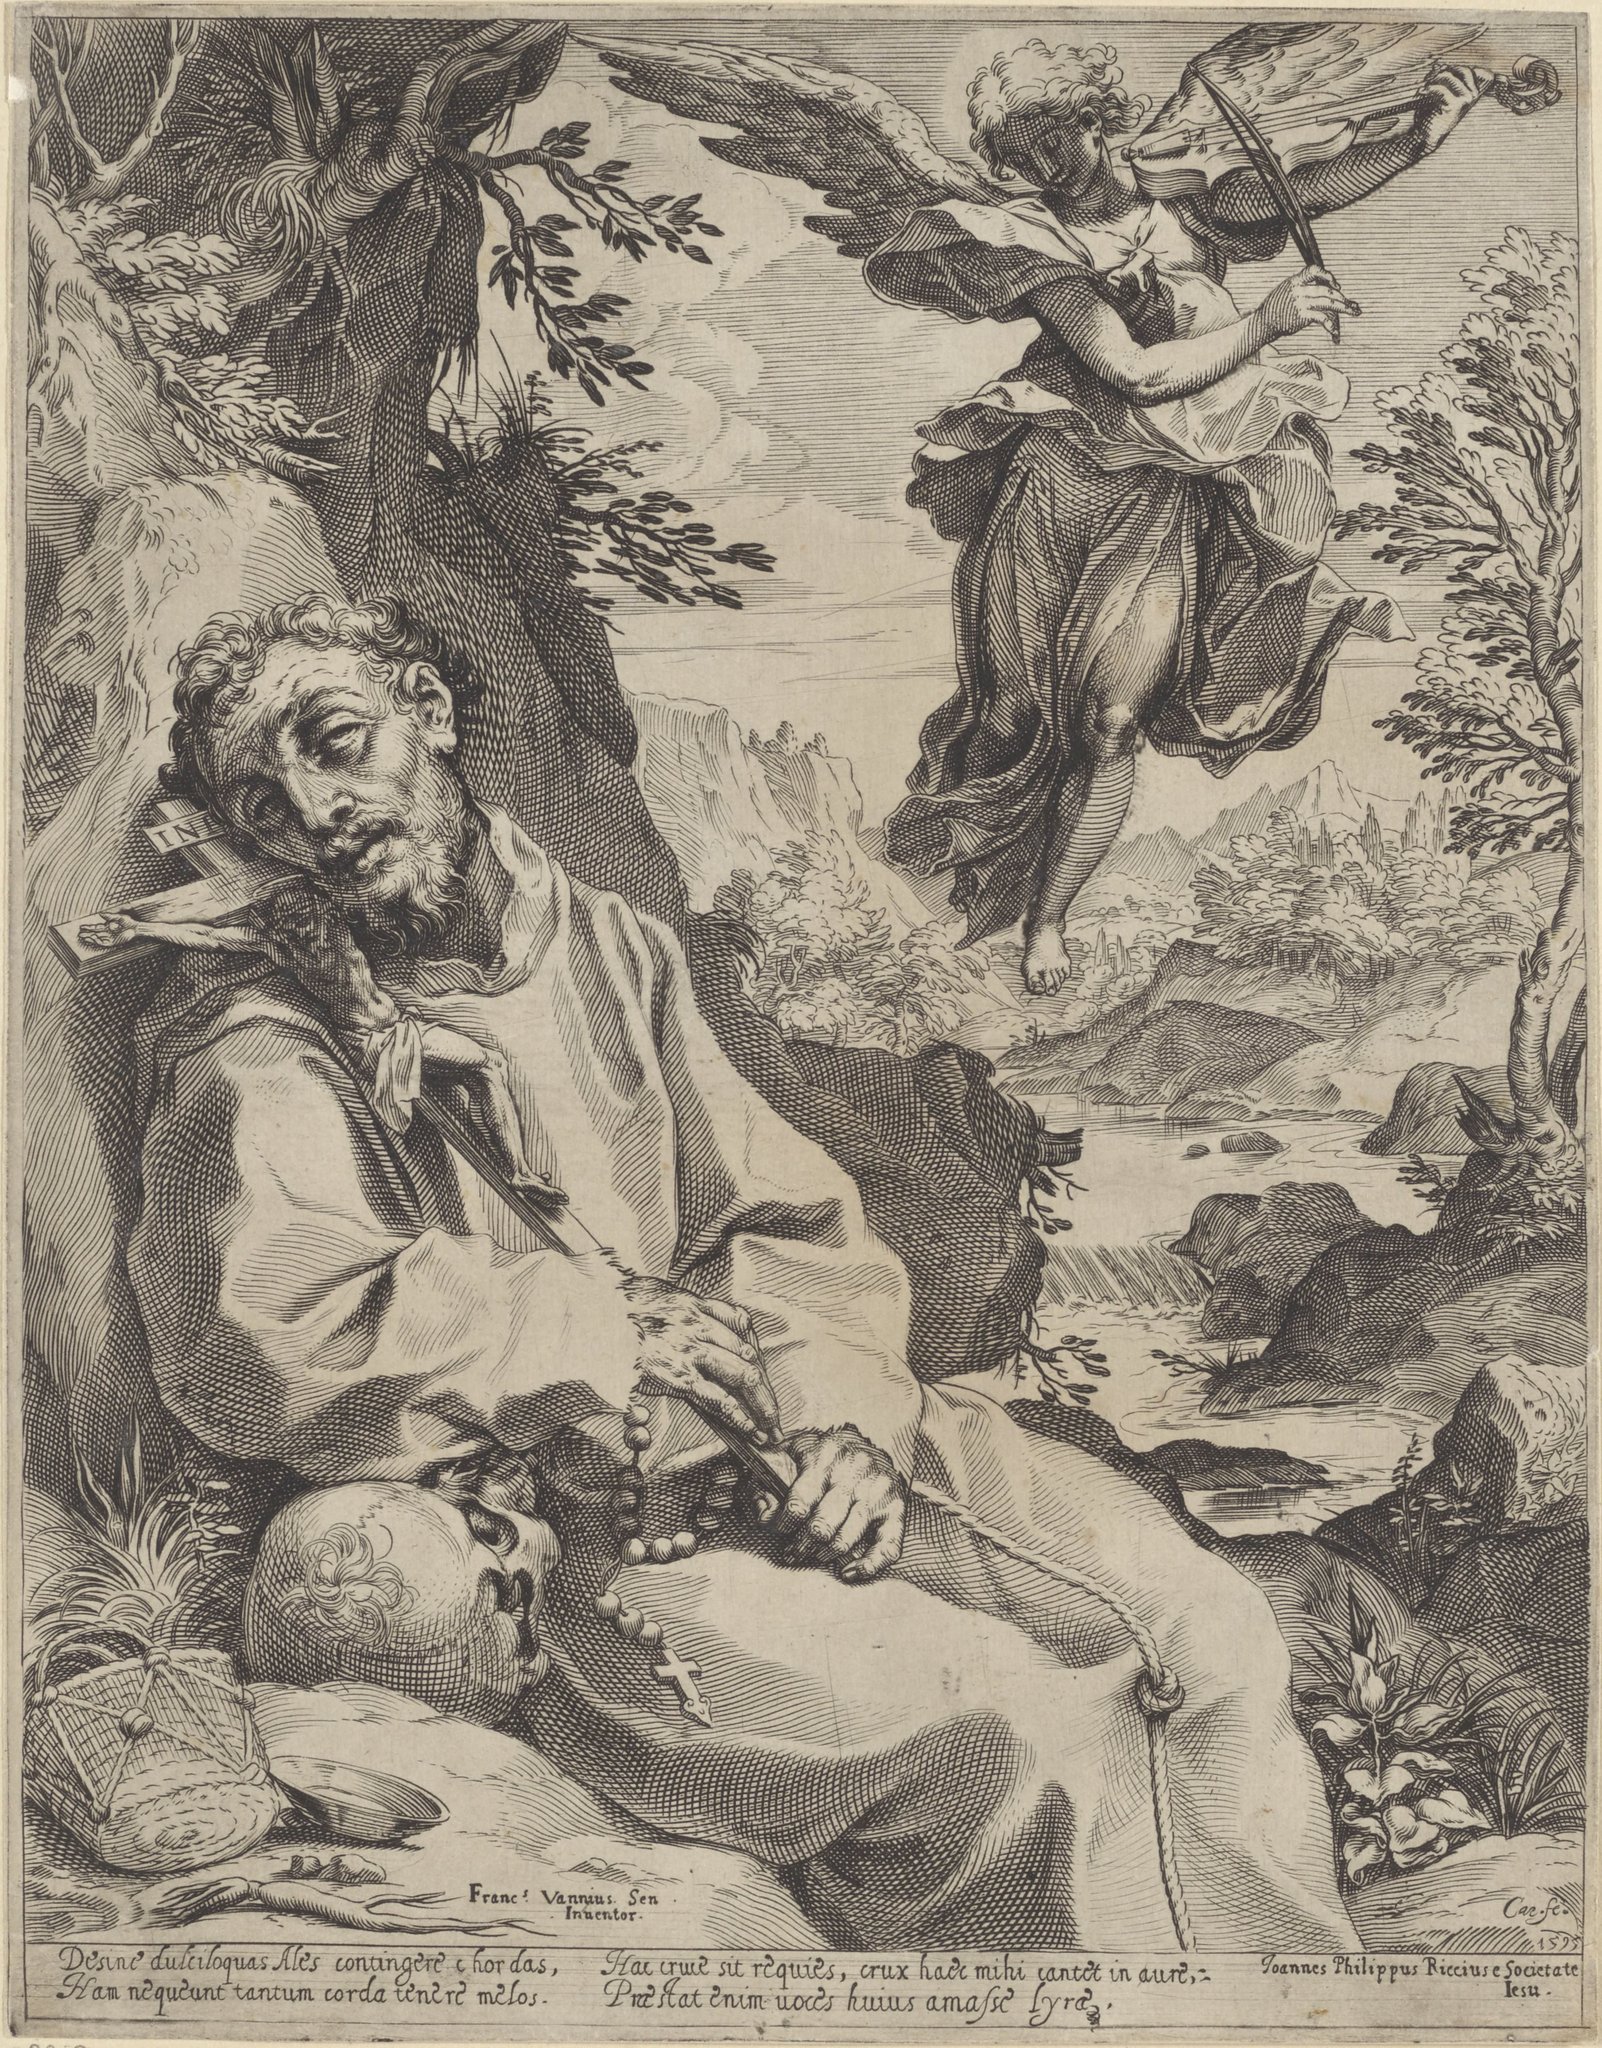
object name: print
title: De heilige Franciscus getroost door een musicerende engel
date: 1595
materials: paper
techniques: engraving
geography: italy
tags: an angel playing the violin appears to st. francis of assisi; francis perhaps on his sickbed, deathbed, or meditating in the open air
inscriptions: collector's mark: Lugt 240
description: Naar een schilderij door Francesco Vanni. Het schilderij bevindt zich in Museo Rizzi te Sestri Levante. Een getekende voorstudie voor de prent door Agostino Carracci bevindt zich in de Staatsgalerie Graphische Sammlung te Stuttgart.